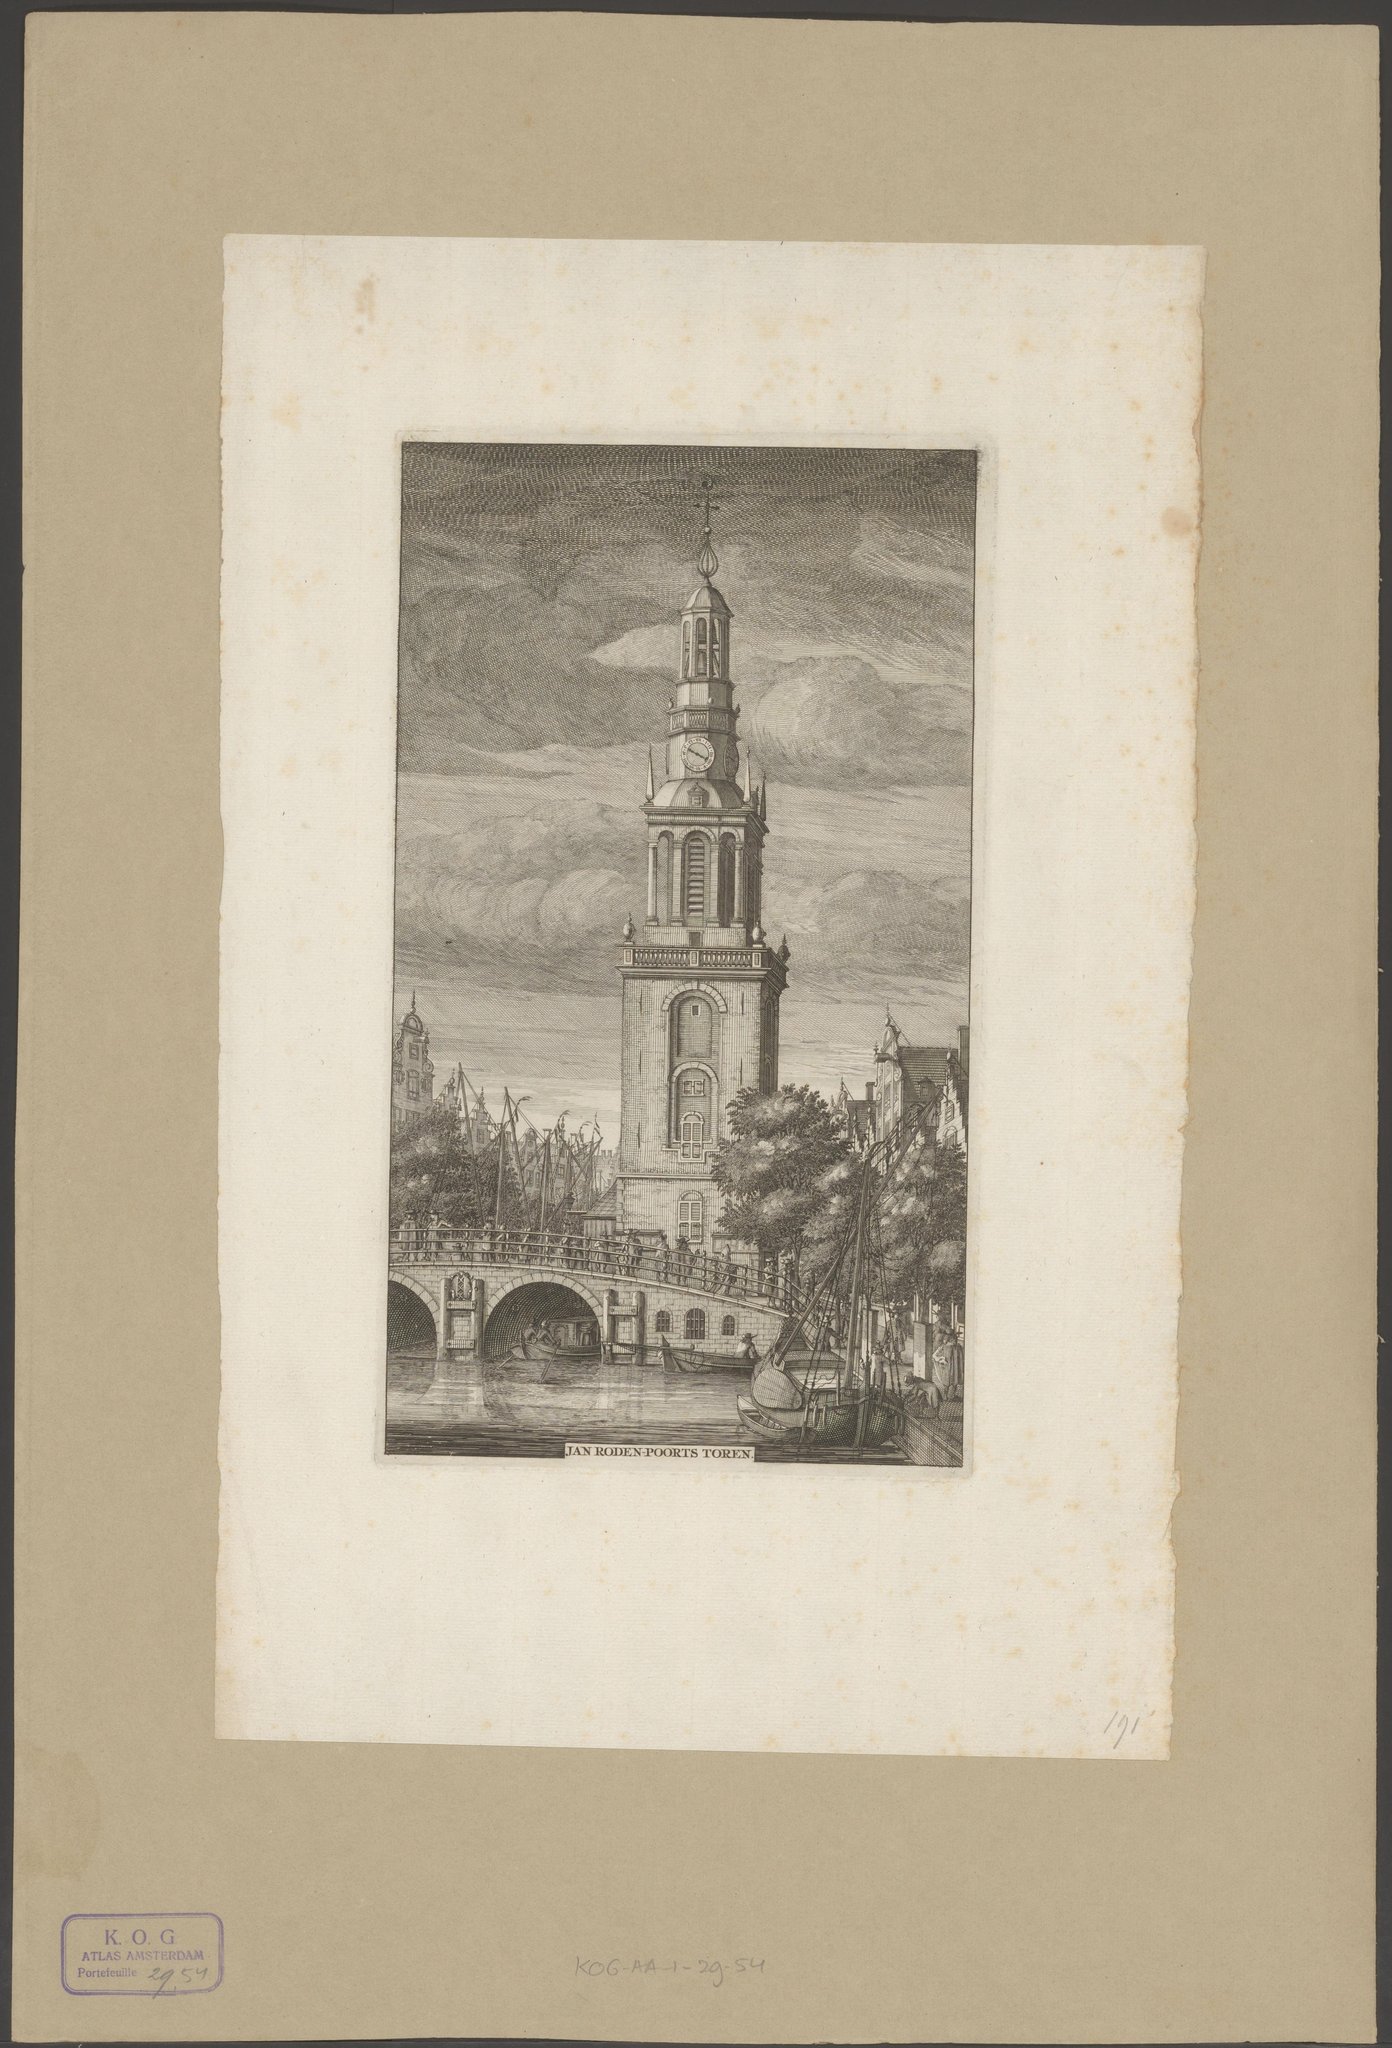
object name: print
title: Jan Roden-Poorts Toren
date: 1726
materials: paper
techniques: engraving, etching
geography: northern netherlands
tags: bridge in city across river, canal, etc. (+ city(-scape) with figures, staffage), sailing-ship, sailing-boat, tower, clock tower ~ monumental adornment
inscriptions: collector's mark: Lugt 1641b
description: Prent mogelijk uit: Commelin, Casparus. Beschryvinge van Amsterdam (…). 2de druk. Amsterdam: Andries van Damme, Johannes Ratelband, weduwe Antony van Aeltwijk en Hermanus Uytwerf, 1726, dl. 2.